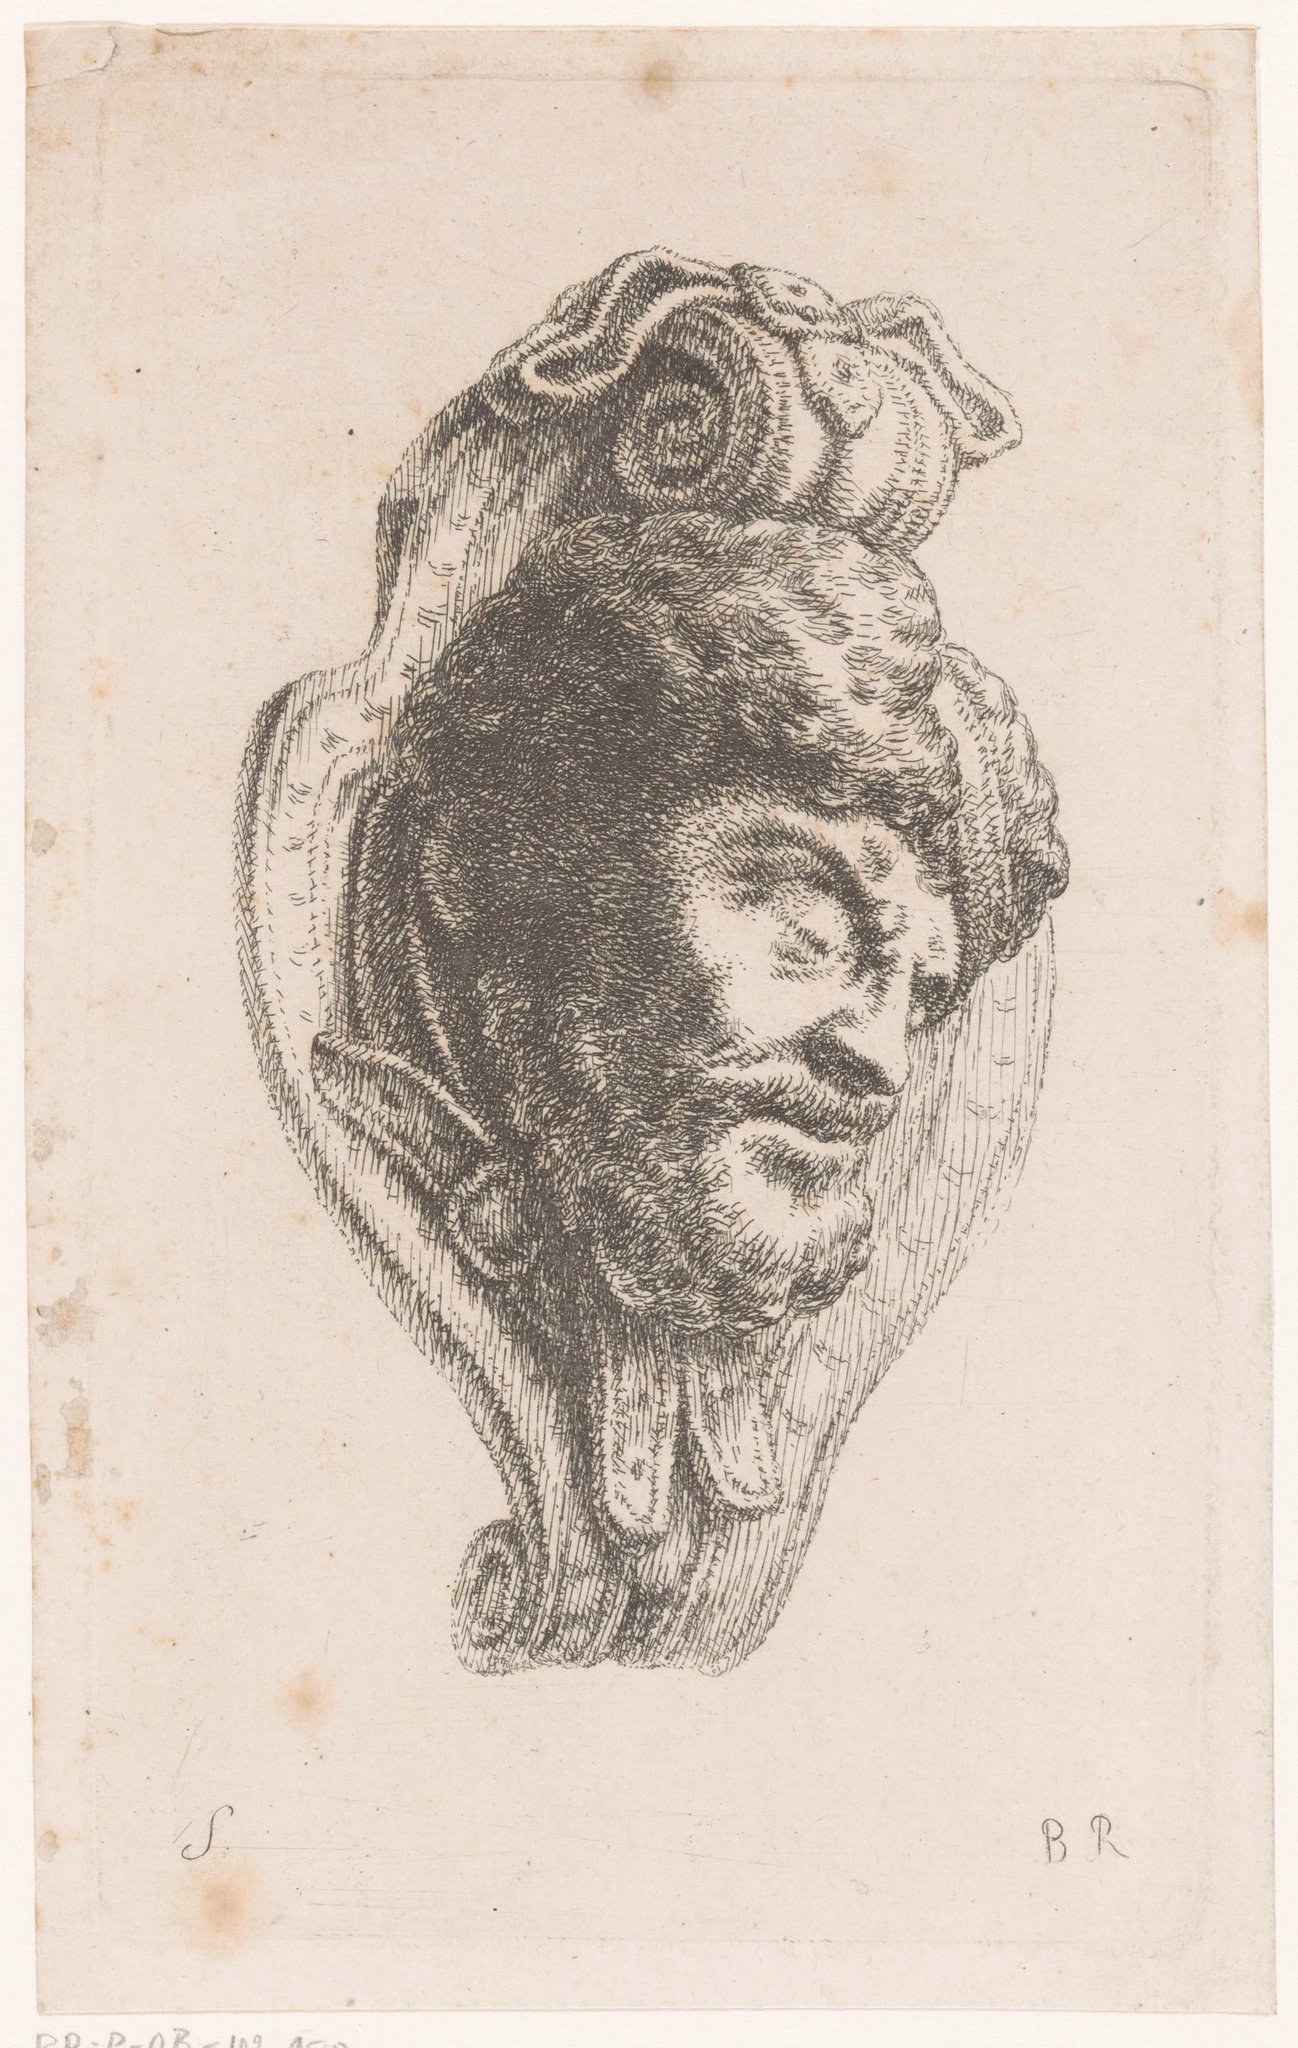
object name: print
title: Mascarons en helmen van het Zeughaus te Berlijn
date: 1735-1797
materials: paper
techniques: etching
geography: berlin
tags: head-gear, mask, mascaron ~ ornament, beard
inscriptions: collector's mark: Lugt 2760, collector's mark: Lugt 2228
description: Het binnenhof van het Zeughaus te Berlijn is versierd met 22 mascarons met hoofden van stervende krijgers.